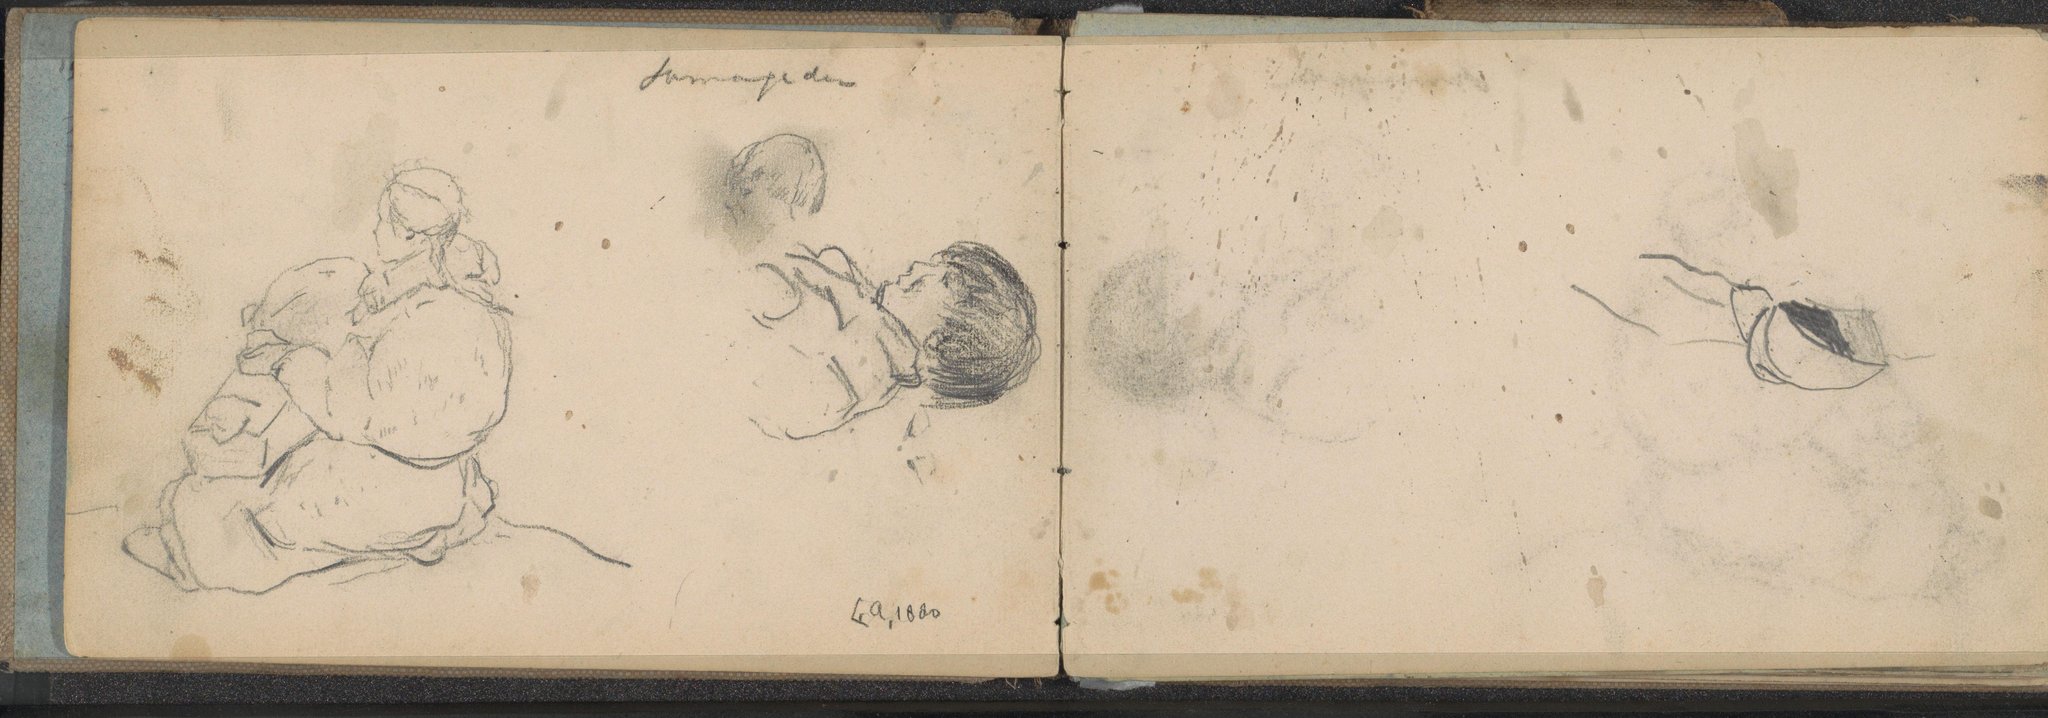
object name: sketchbook leaf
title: Samojeden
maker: louis apol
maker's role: draughtsman, painter, print maker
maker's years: 1850-1936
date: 1880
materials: chalk, paper, pencil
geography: malye karmakuly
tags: adult woman, adult man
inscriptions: date: ‘1880’, annotation: ‘Samojeden’, signature: ‘L.A.’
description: Links een zittende vrouw met kind. Blad 3 verso uit een schetsboek met 35 bladen betekend tijdens de expeditie naar Nova Zembla in 1880.